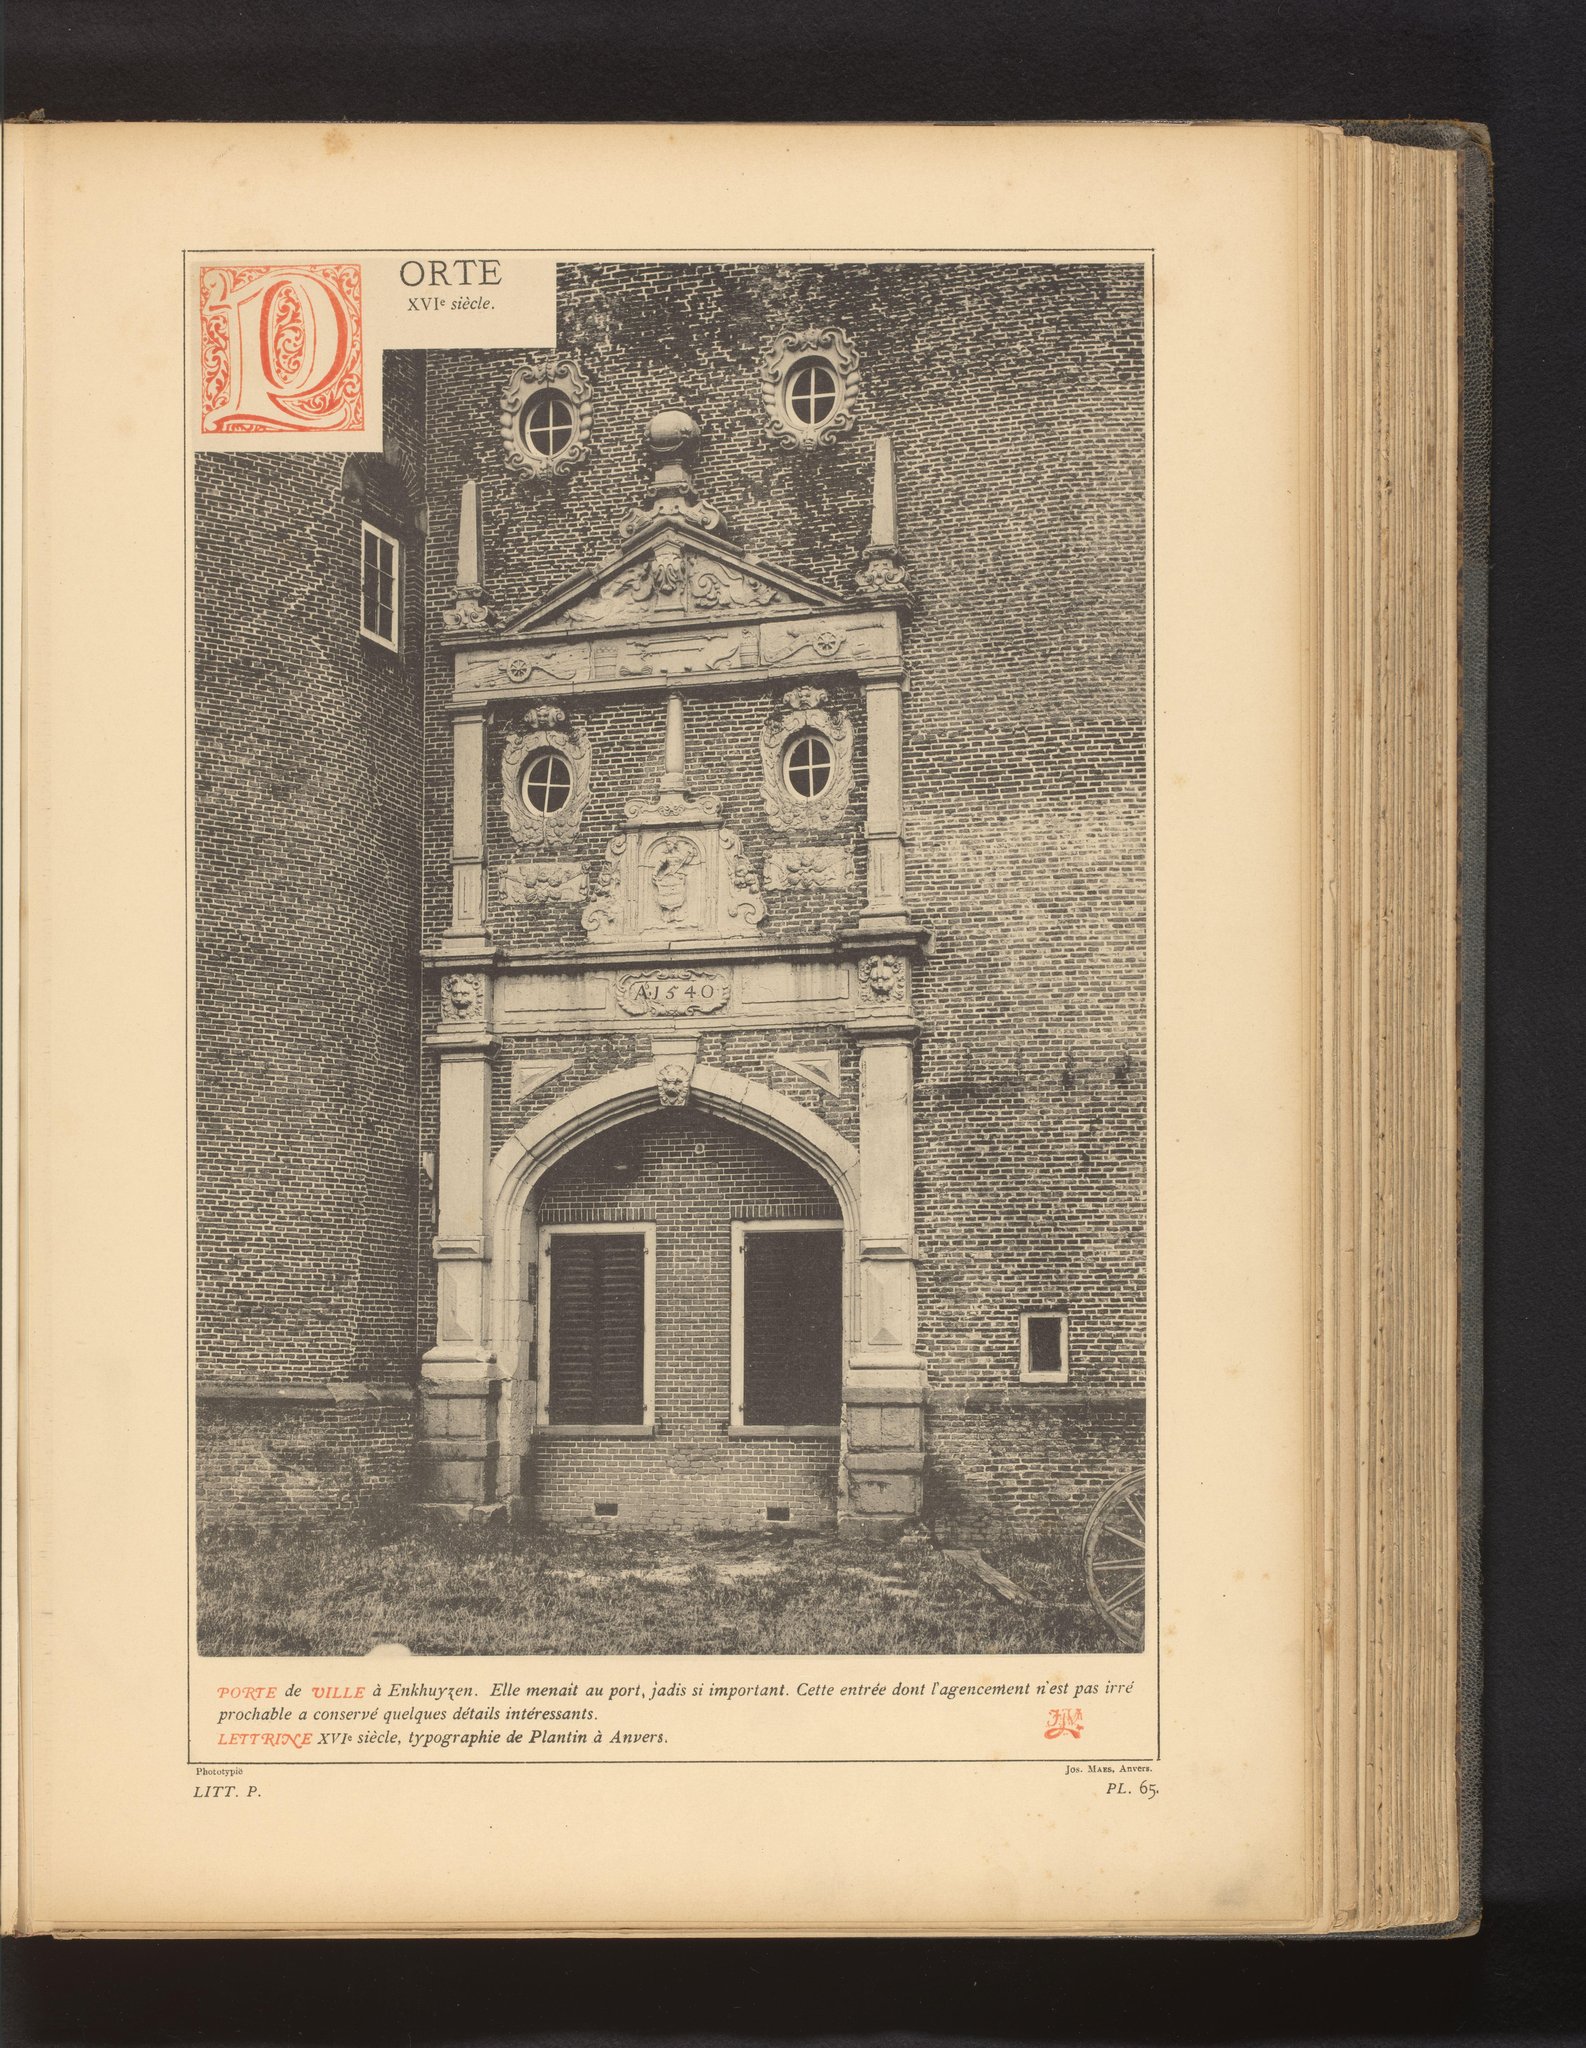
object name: photomechanical print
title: Porte, XVIe Siècle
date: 1876-1881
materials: paper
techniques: photograph, photolithography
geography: antwerp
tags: city-gate, enkhuizen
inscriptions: inscription: ‘PORTE DE VILLE (...)’, inscription: ‘LITT. P. - PL. 65.’, monogram: ‘JJvY’